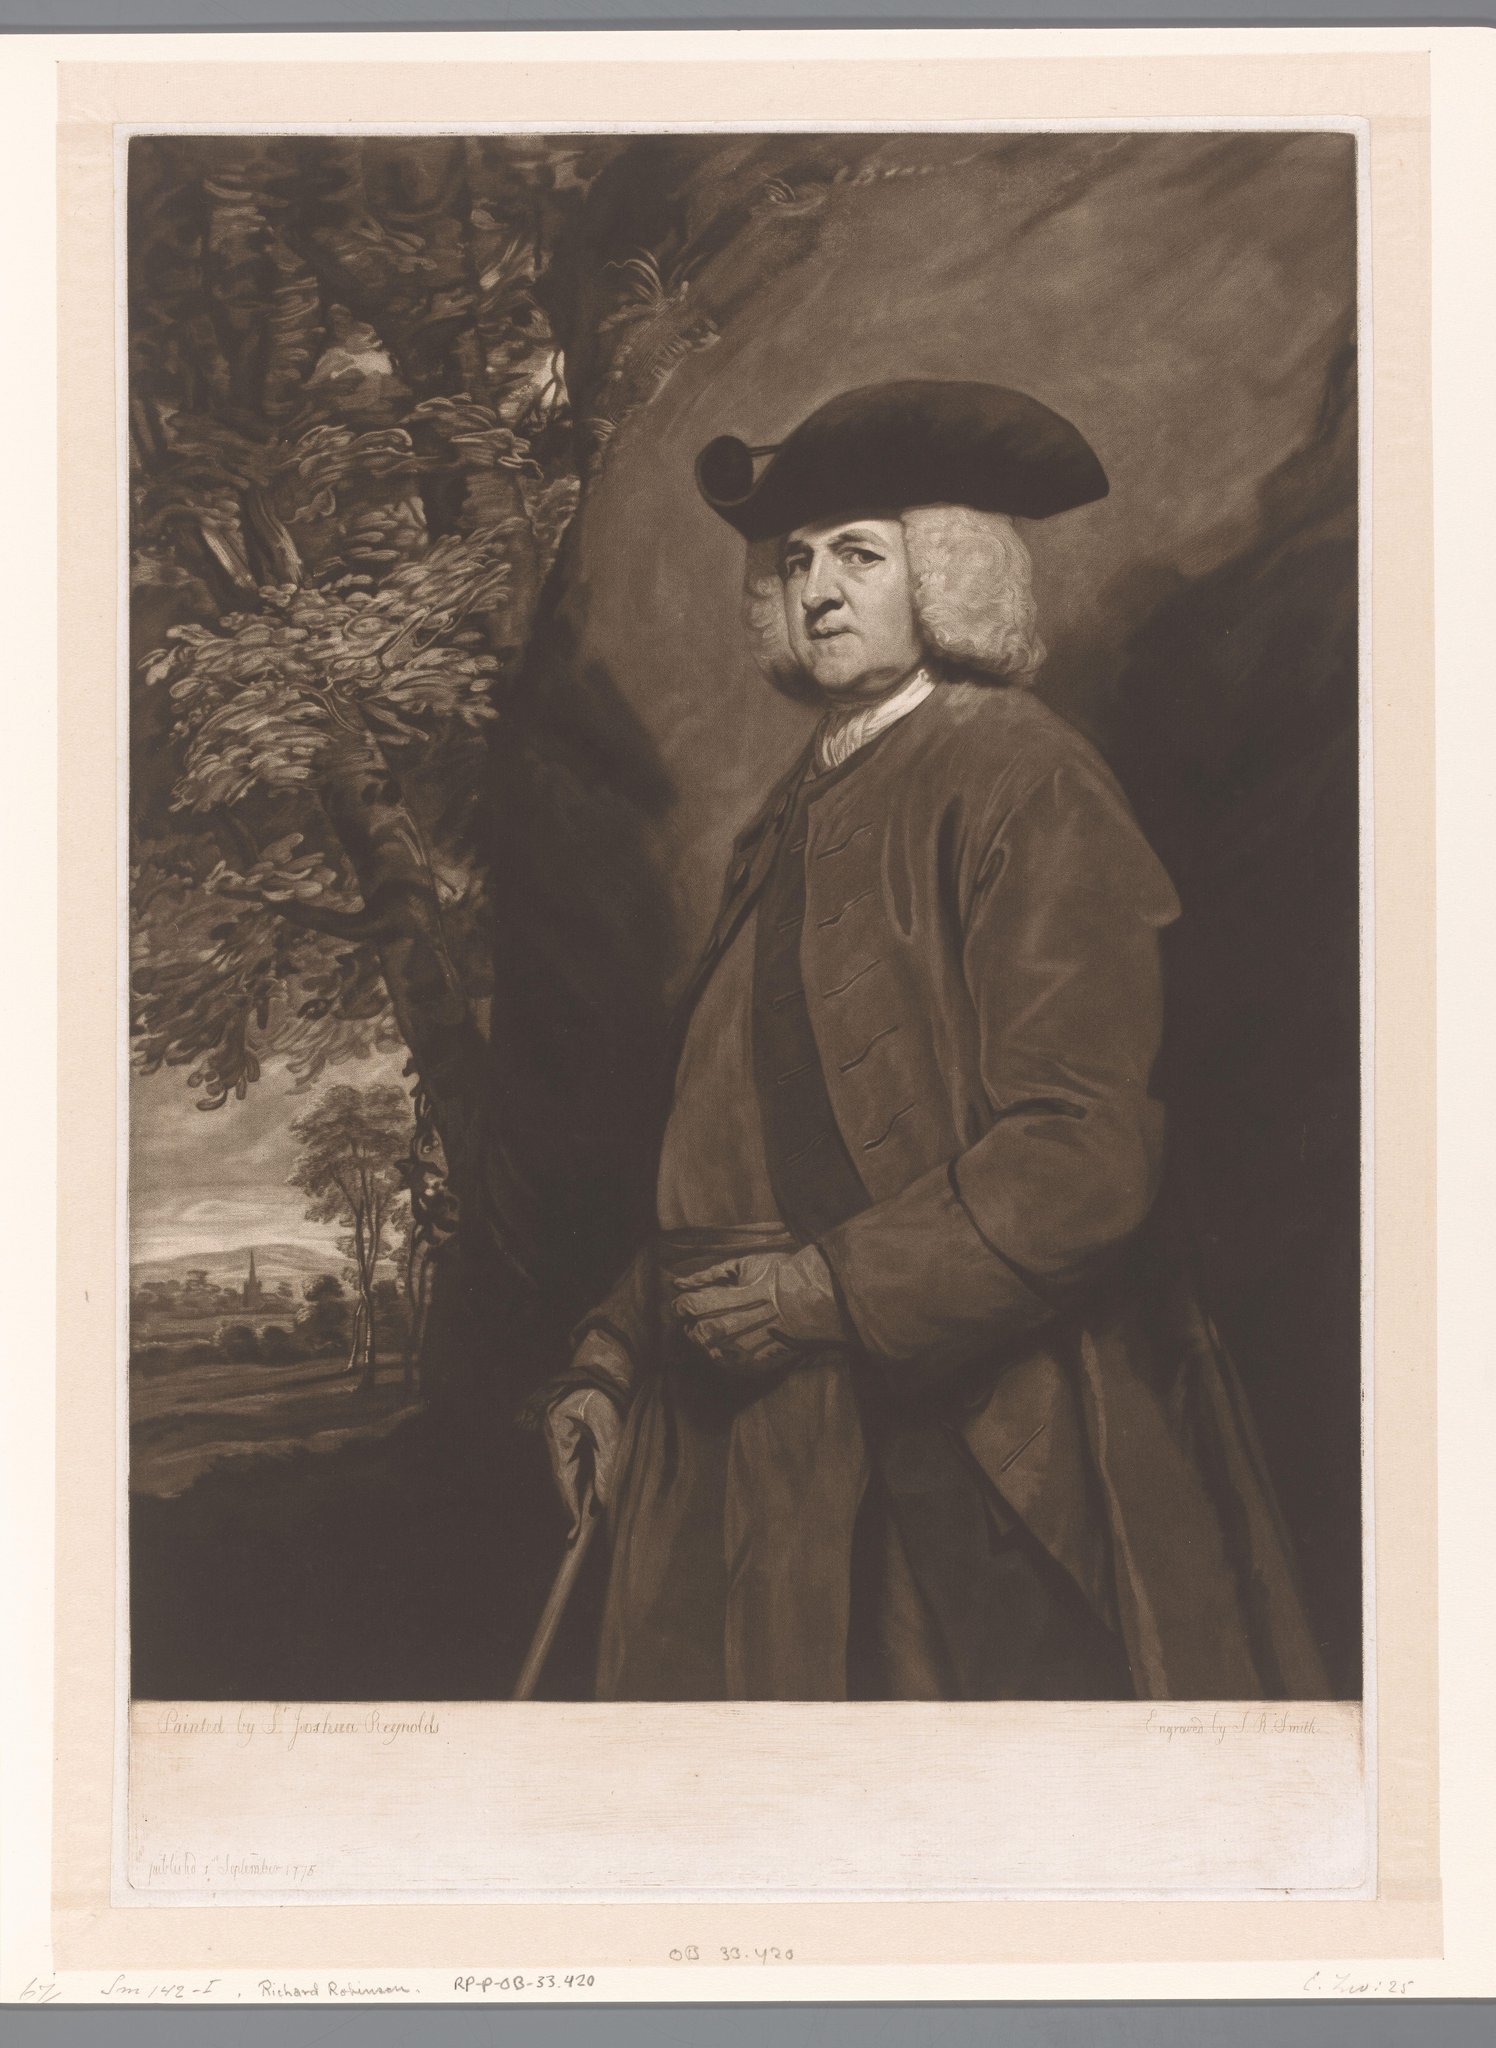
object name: print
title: Portret van Richard Robinson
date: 1709-1775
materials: paper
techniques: mezzotint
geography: london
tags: archbishop, bishop, etc. (roman catholic), historical persons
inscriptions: date